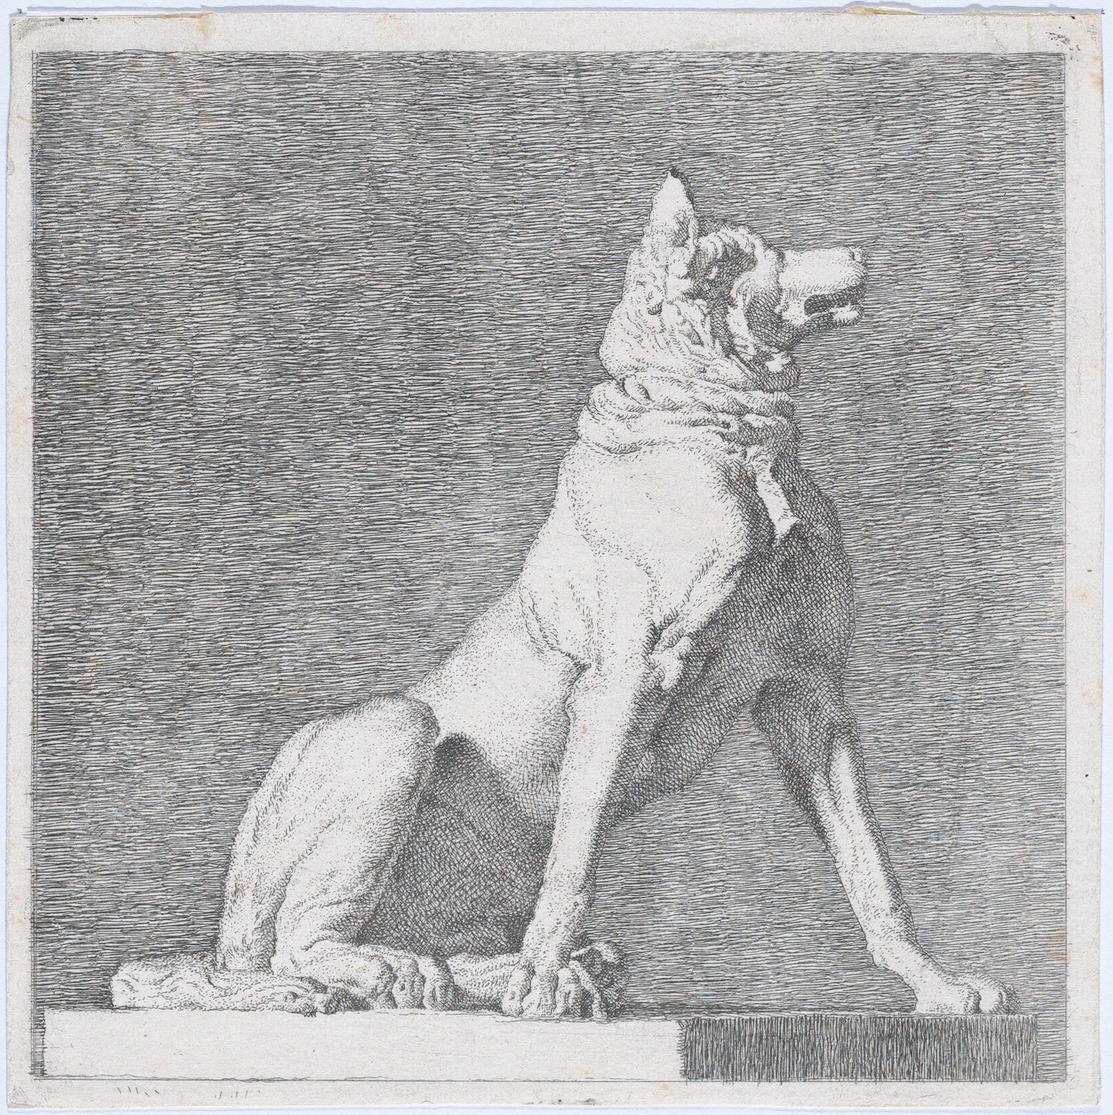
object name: print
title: Seated Dog, after an antique sculpture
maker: christen købke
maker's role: artist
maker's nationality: danish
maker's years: 1810-1848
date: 1838-1840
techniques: etching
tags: dogs